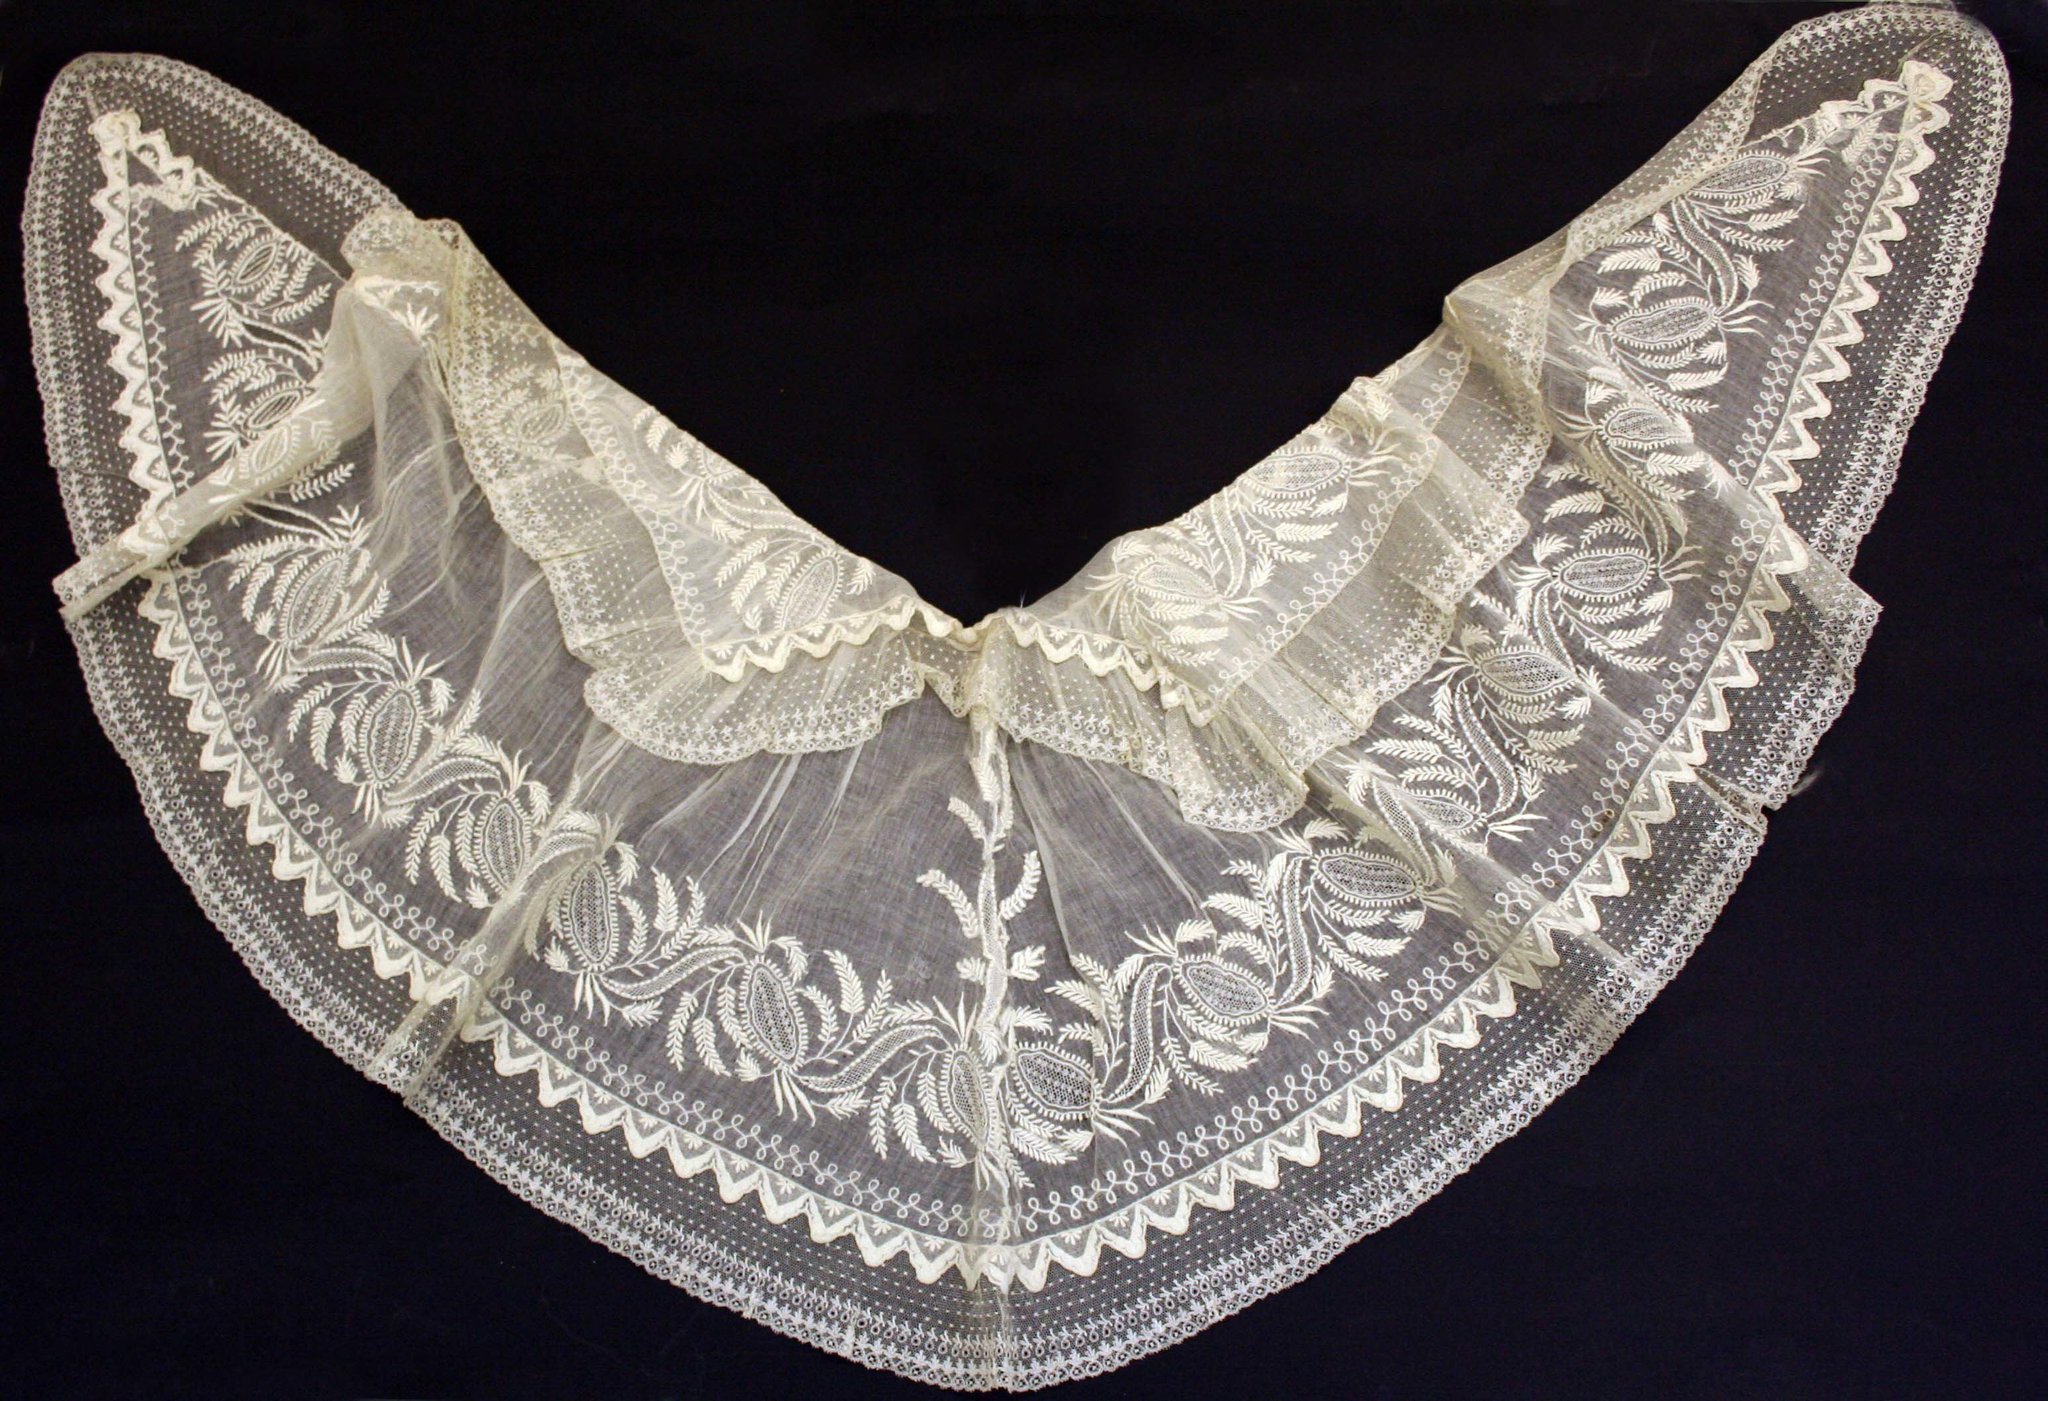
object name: pelerine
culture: british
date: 1775-1825